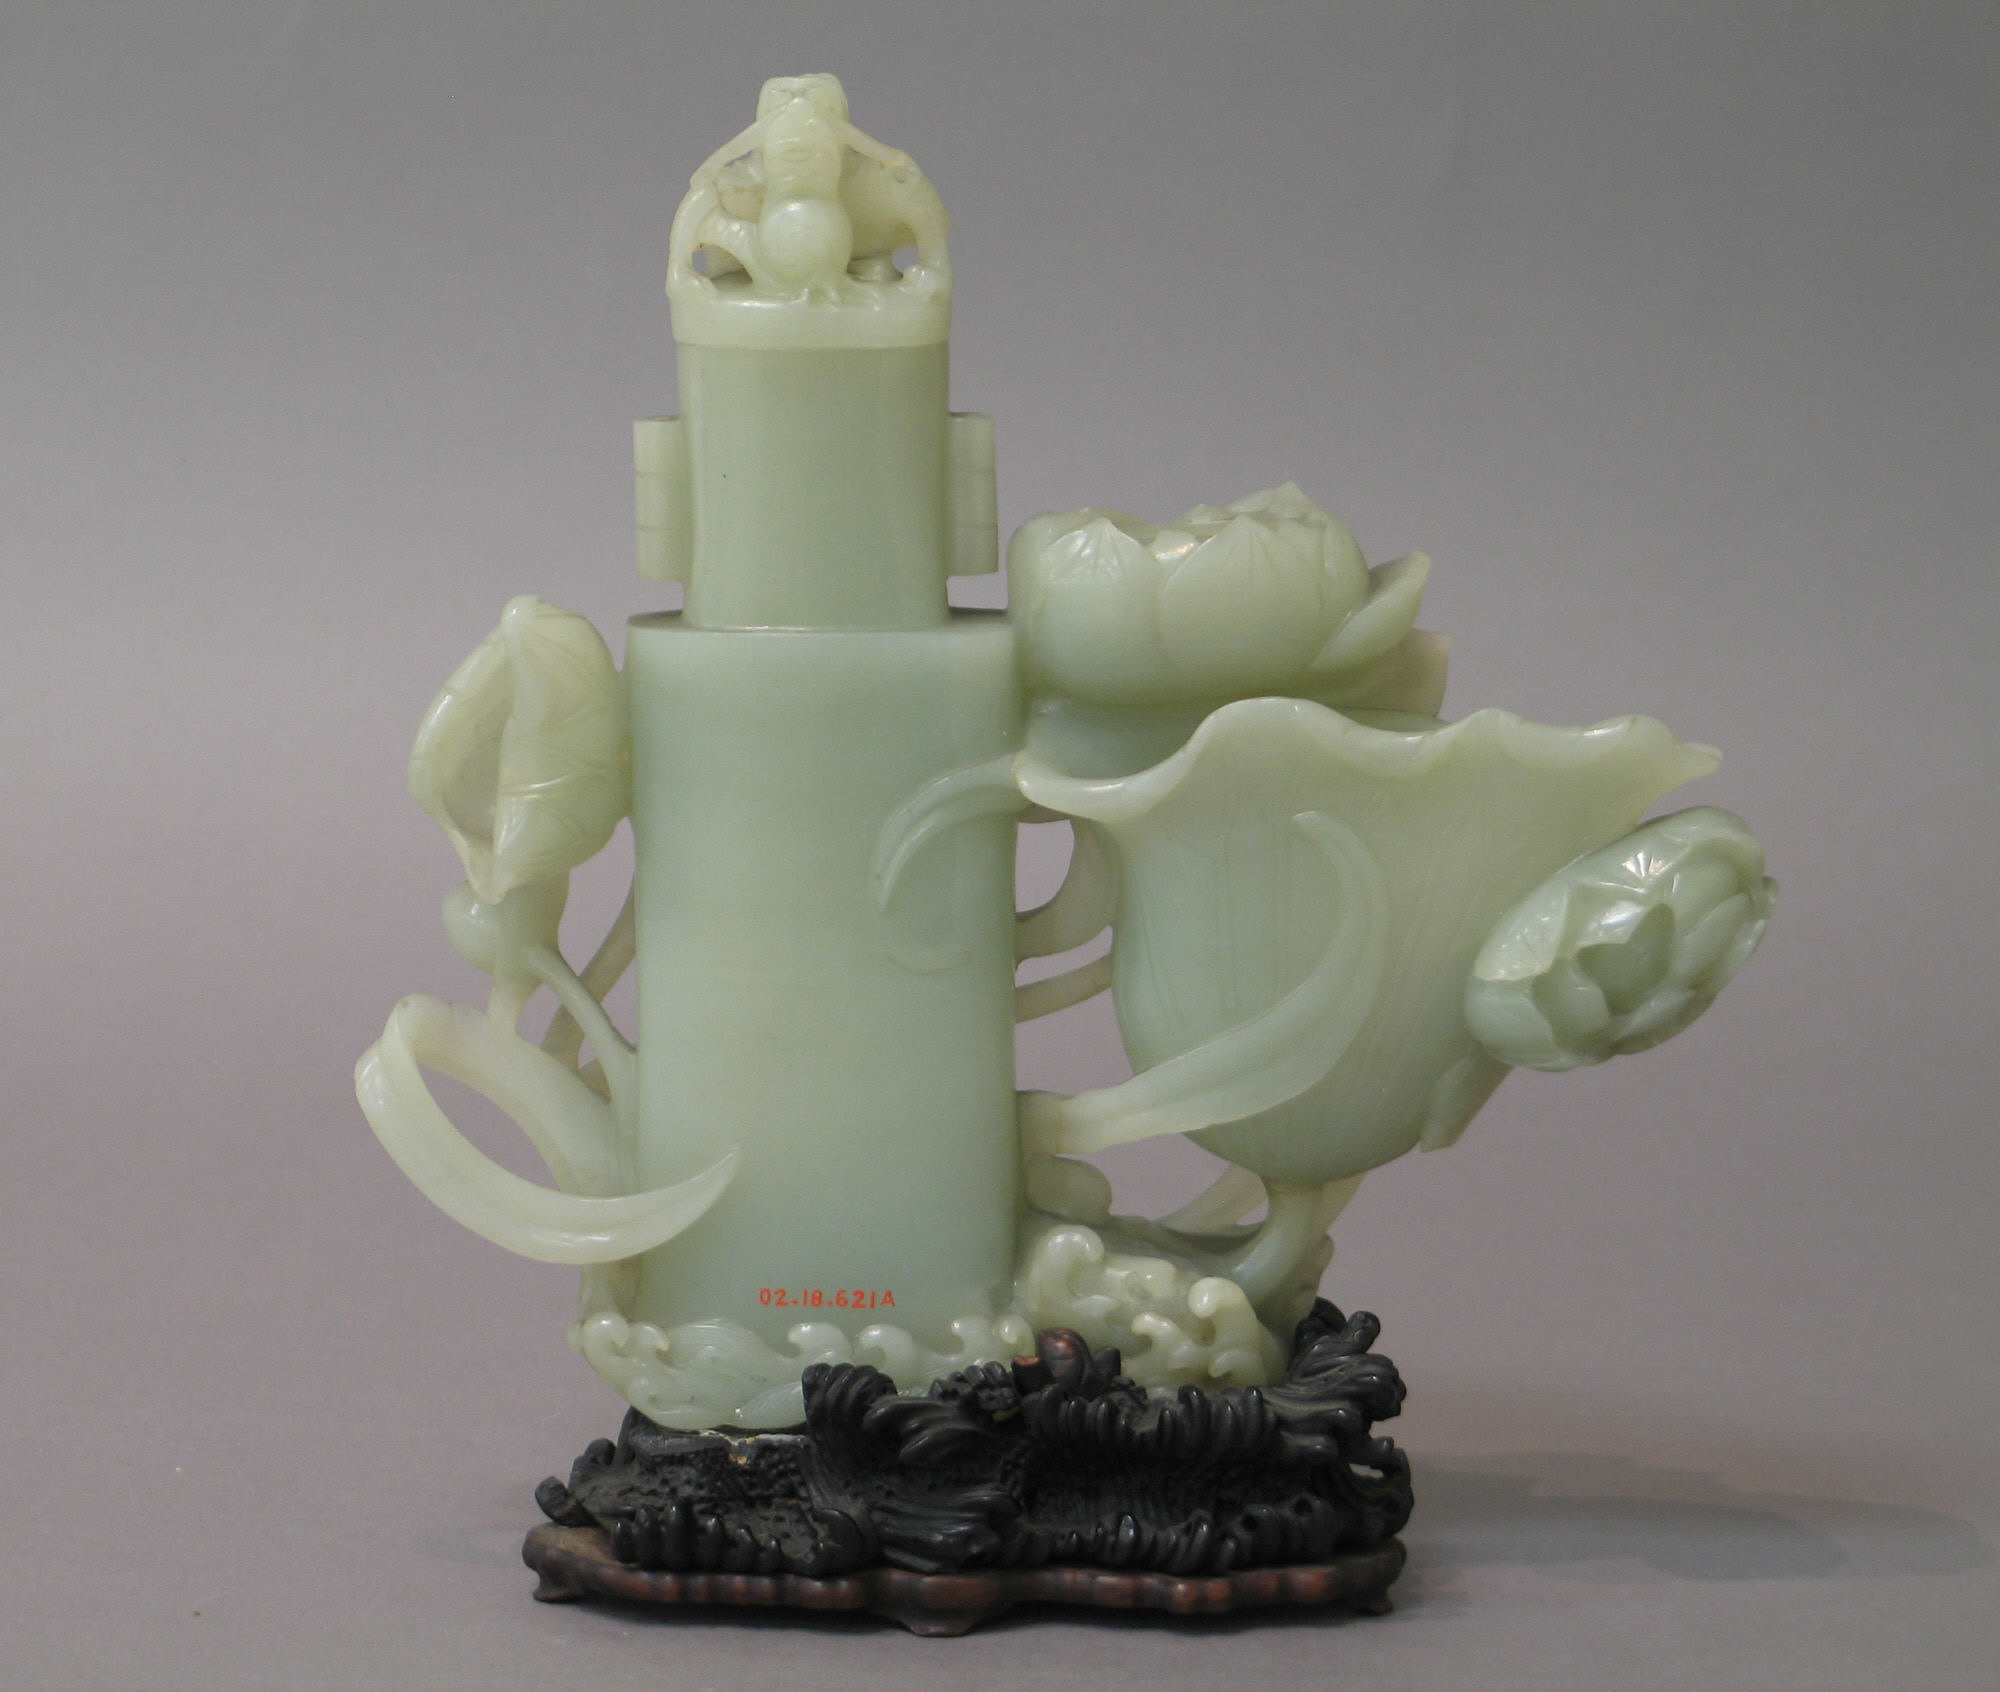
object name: vase with cover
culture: chinese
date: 1736-1795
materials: jade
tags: roses